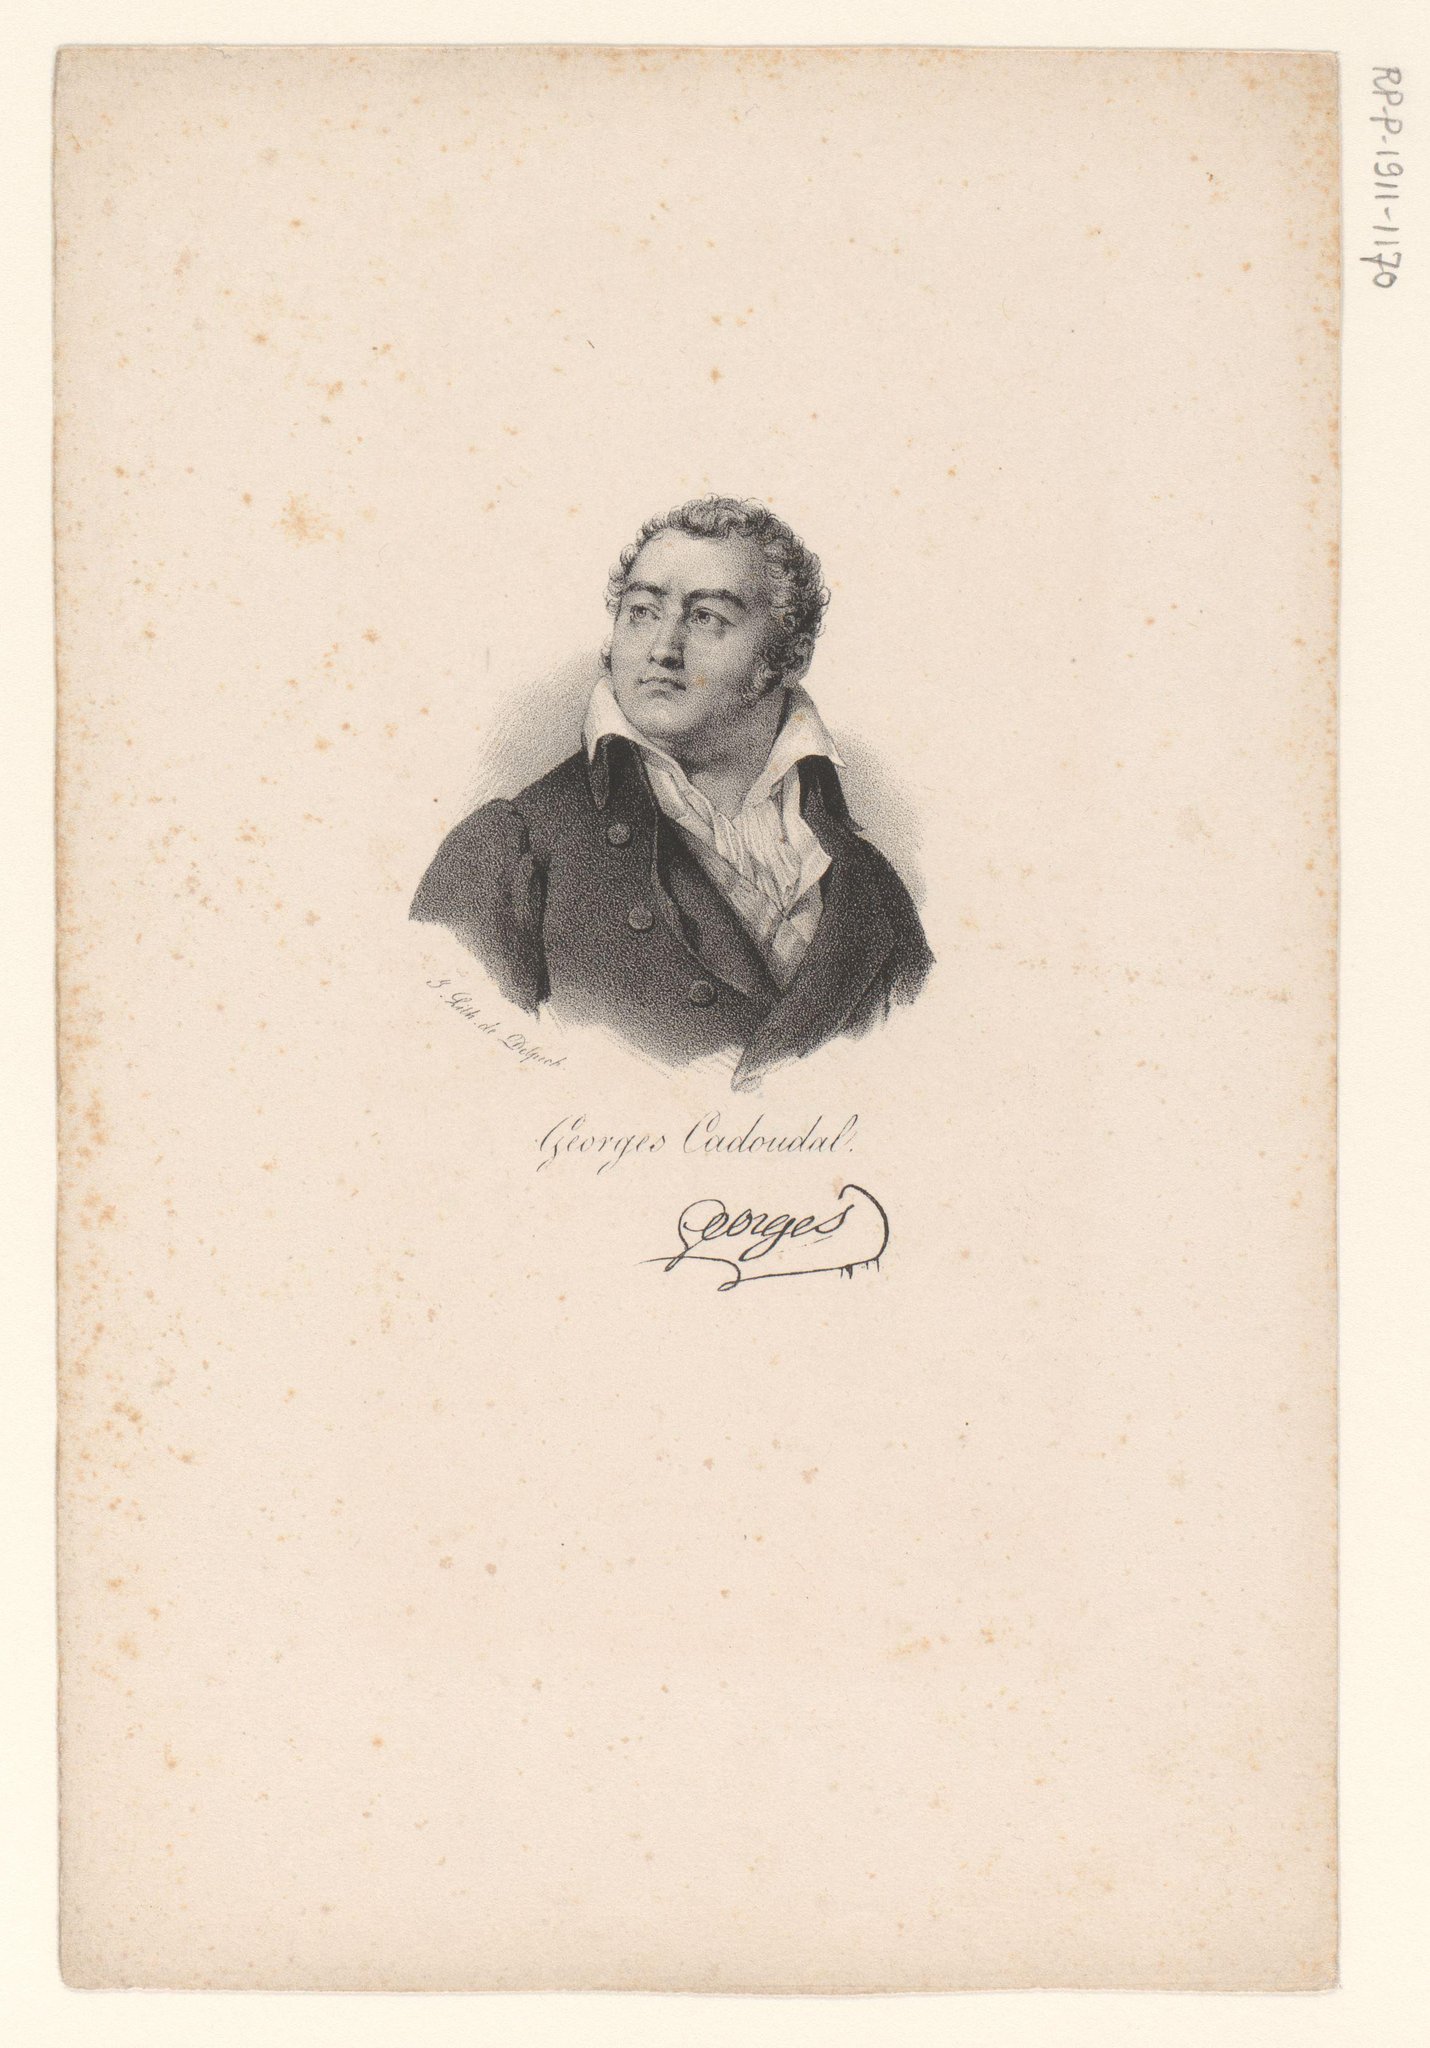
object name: print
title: Georges Cadoudal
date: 1818-1842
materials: paper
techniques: lithograph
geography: paris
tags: historical persons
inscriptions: collector's mark: Lugt 2228a